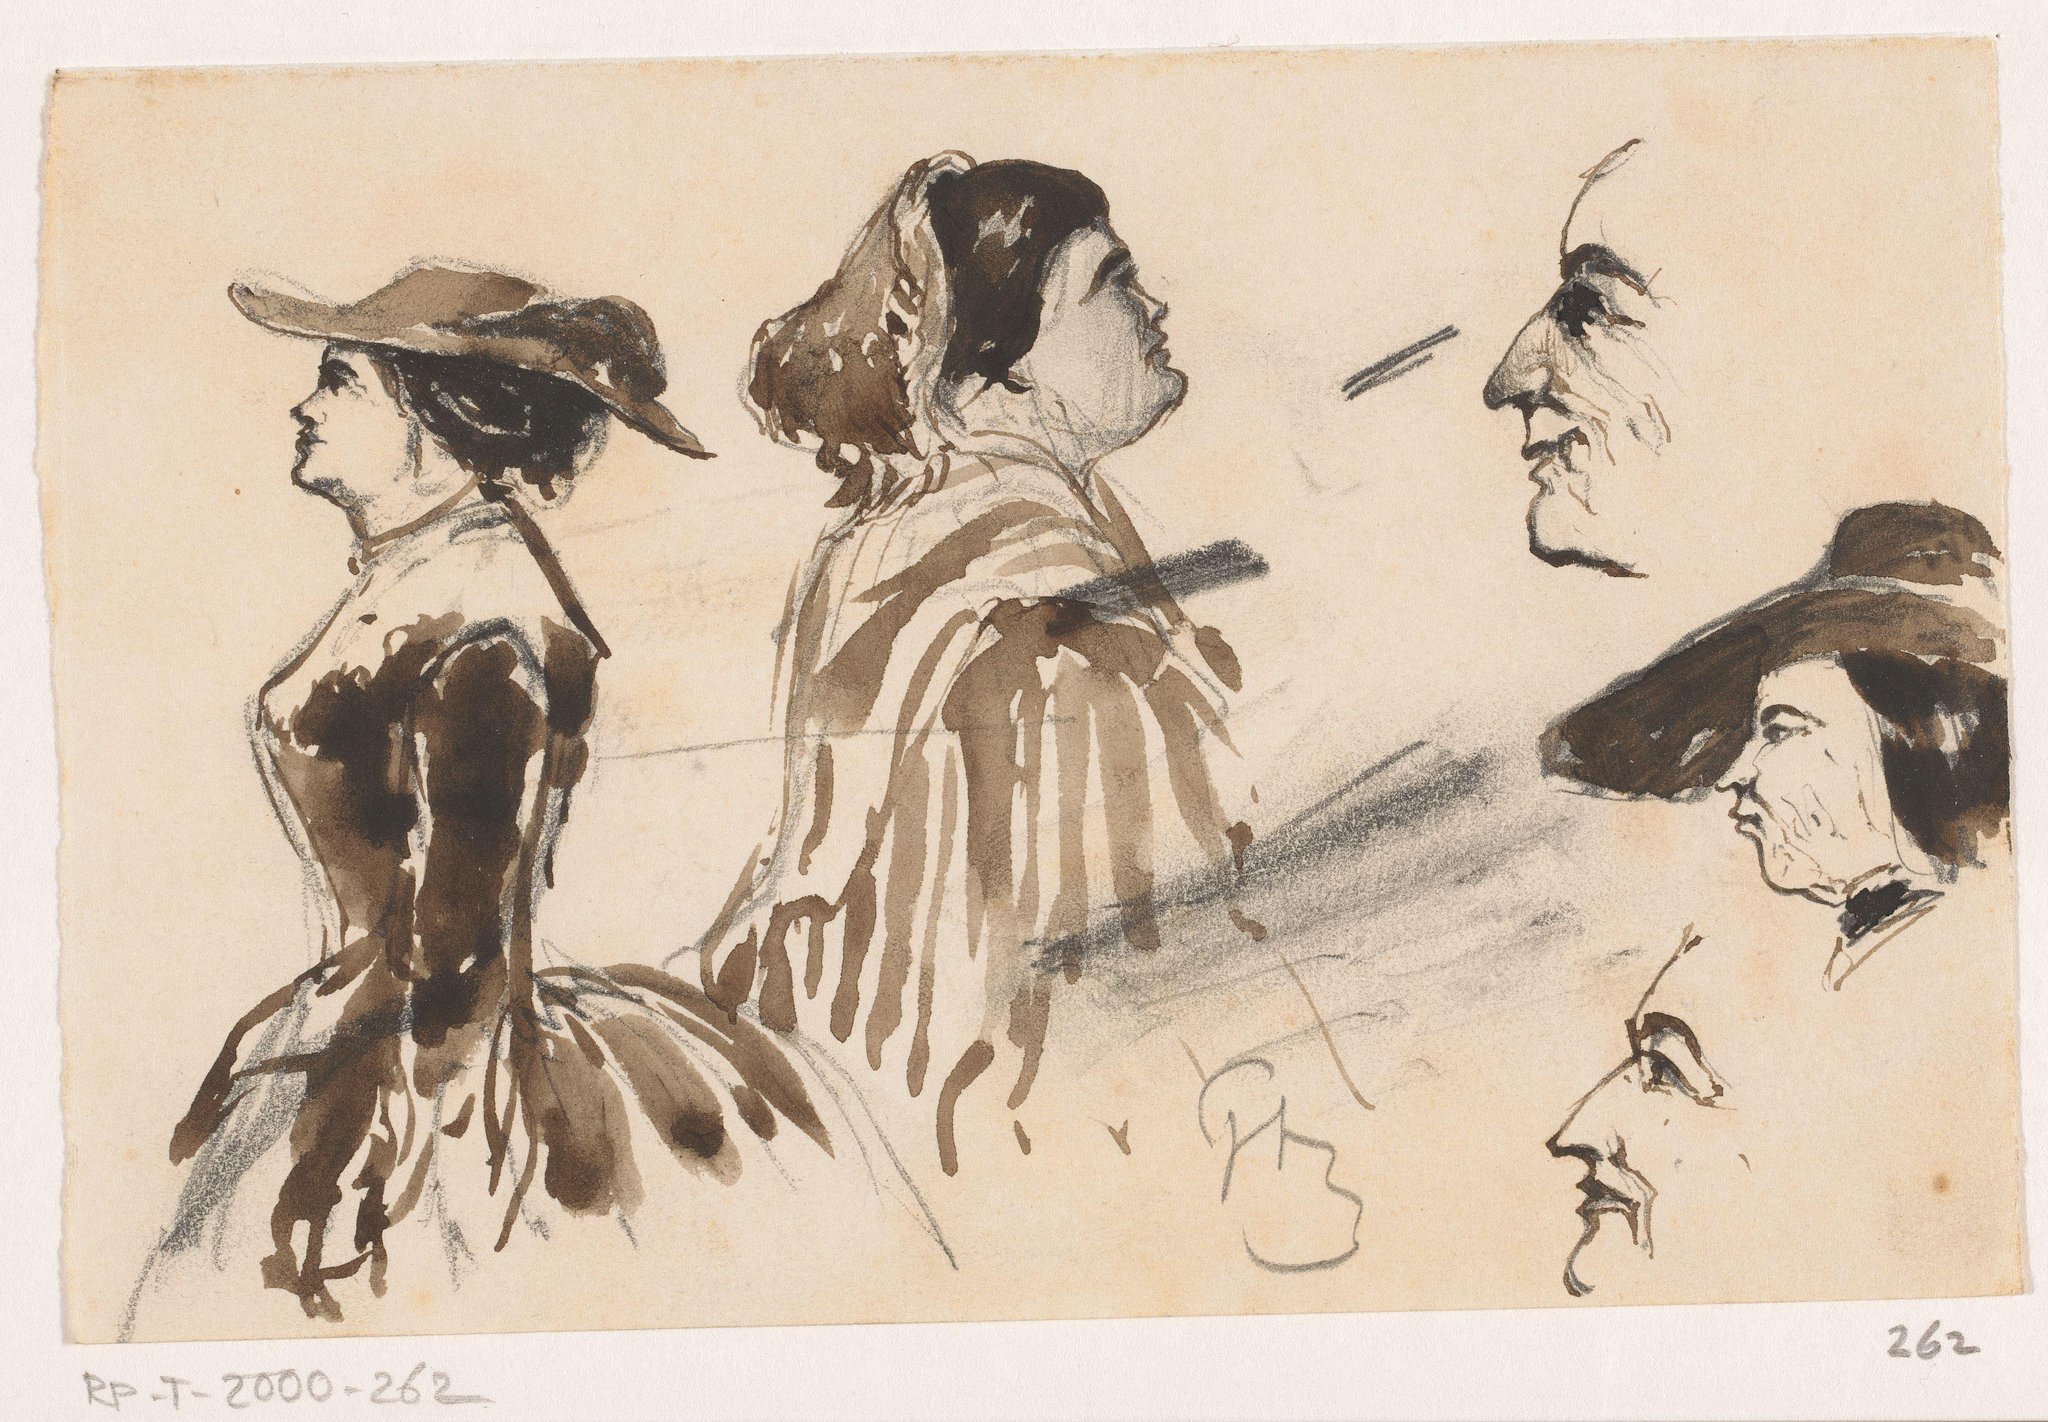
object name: drawing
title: Vrouwen en koppen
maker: johannes tavenraat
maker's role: draughtsman, painter, print maker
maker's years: 1809-1881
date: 1840-1880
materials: ink, paper, pencil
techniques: brush, pen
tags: caricatures (human types), folk costume, regional costume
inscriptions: signature: ‘JT’, collector's mark: Lugt 2228